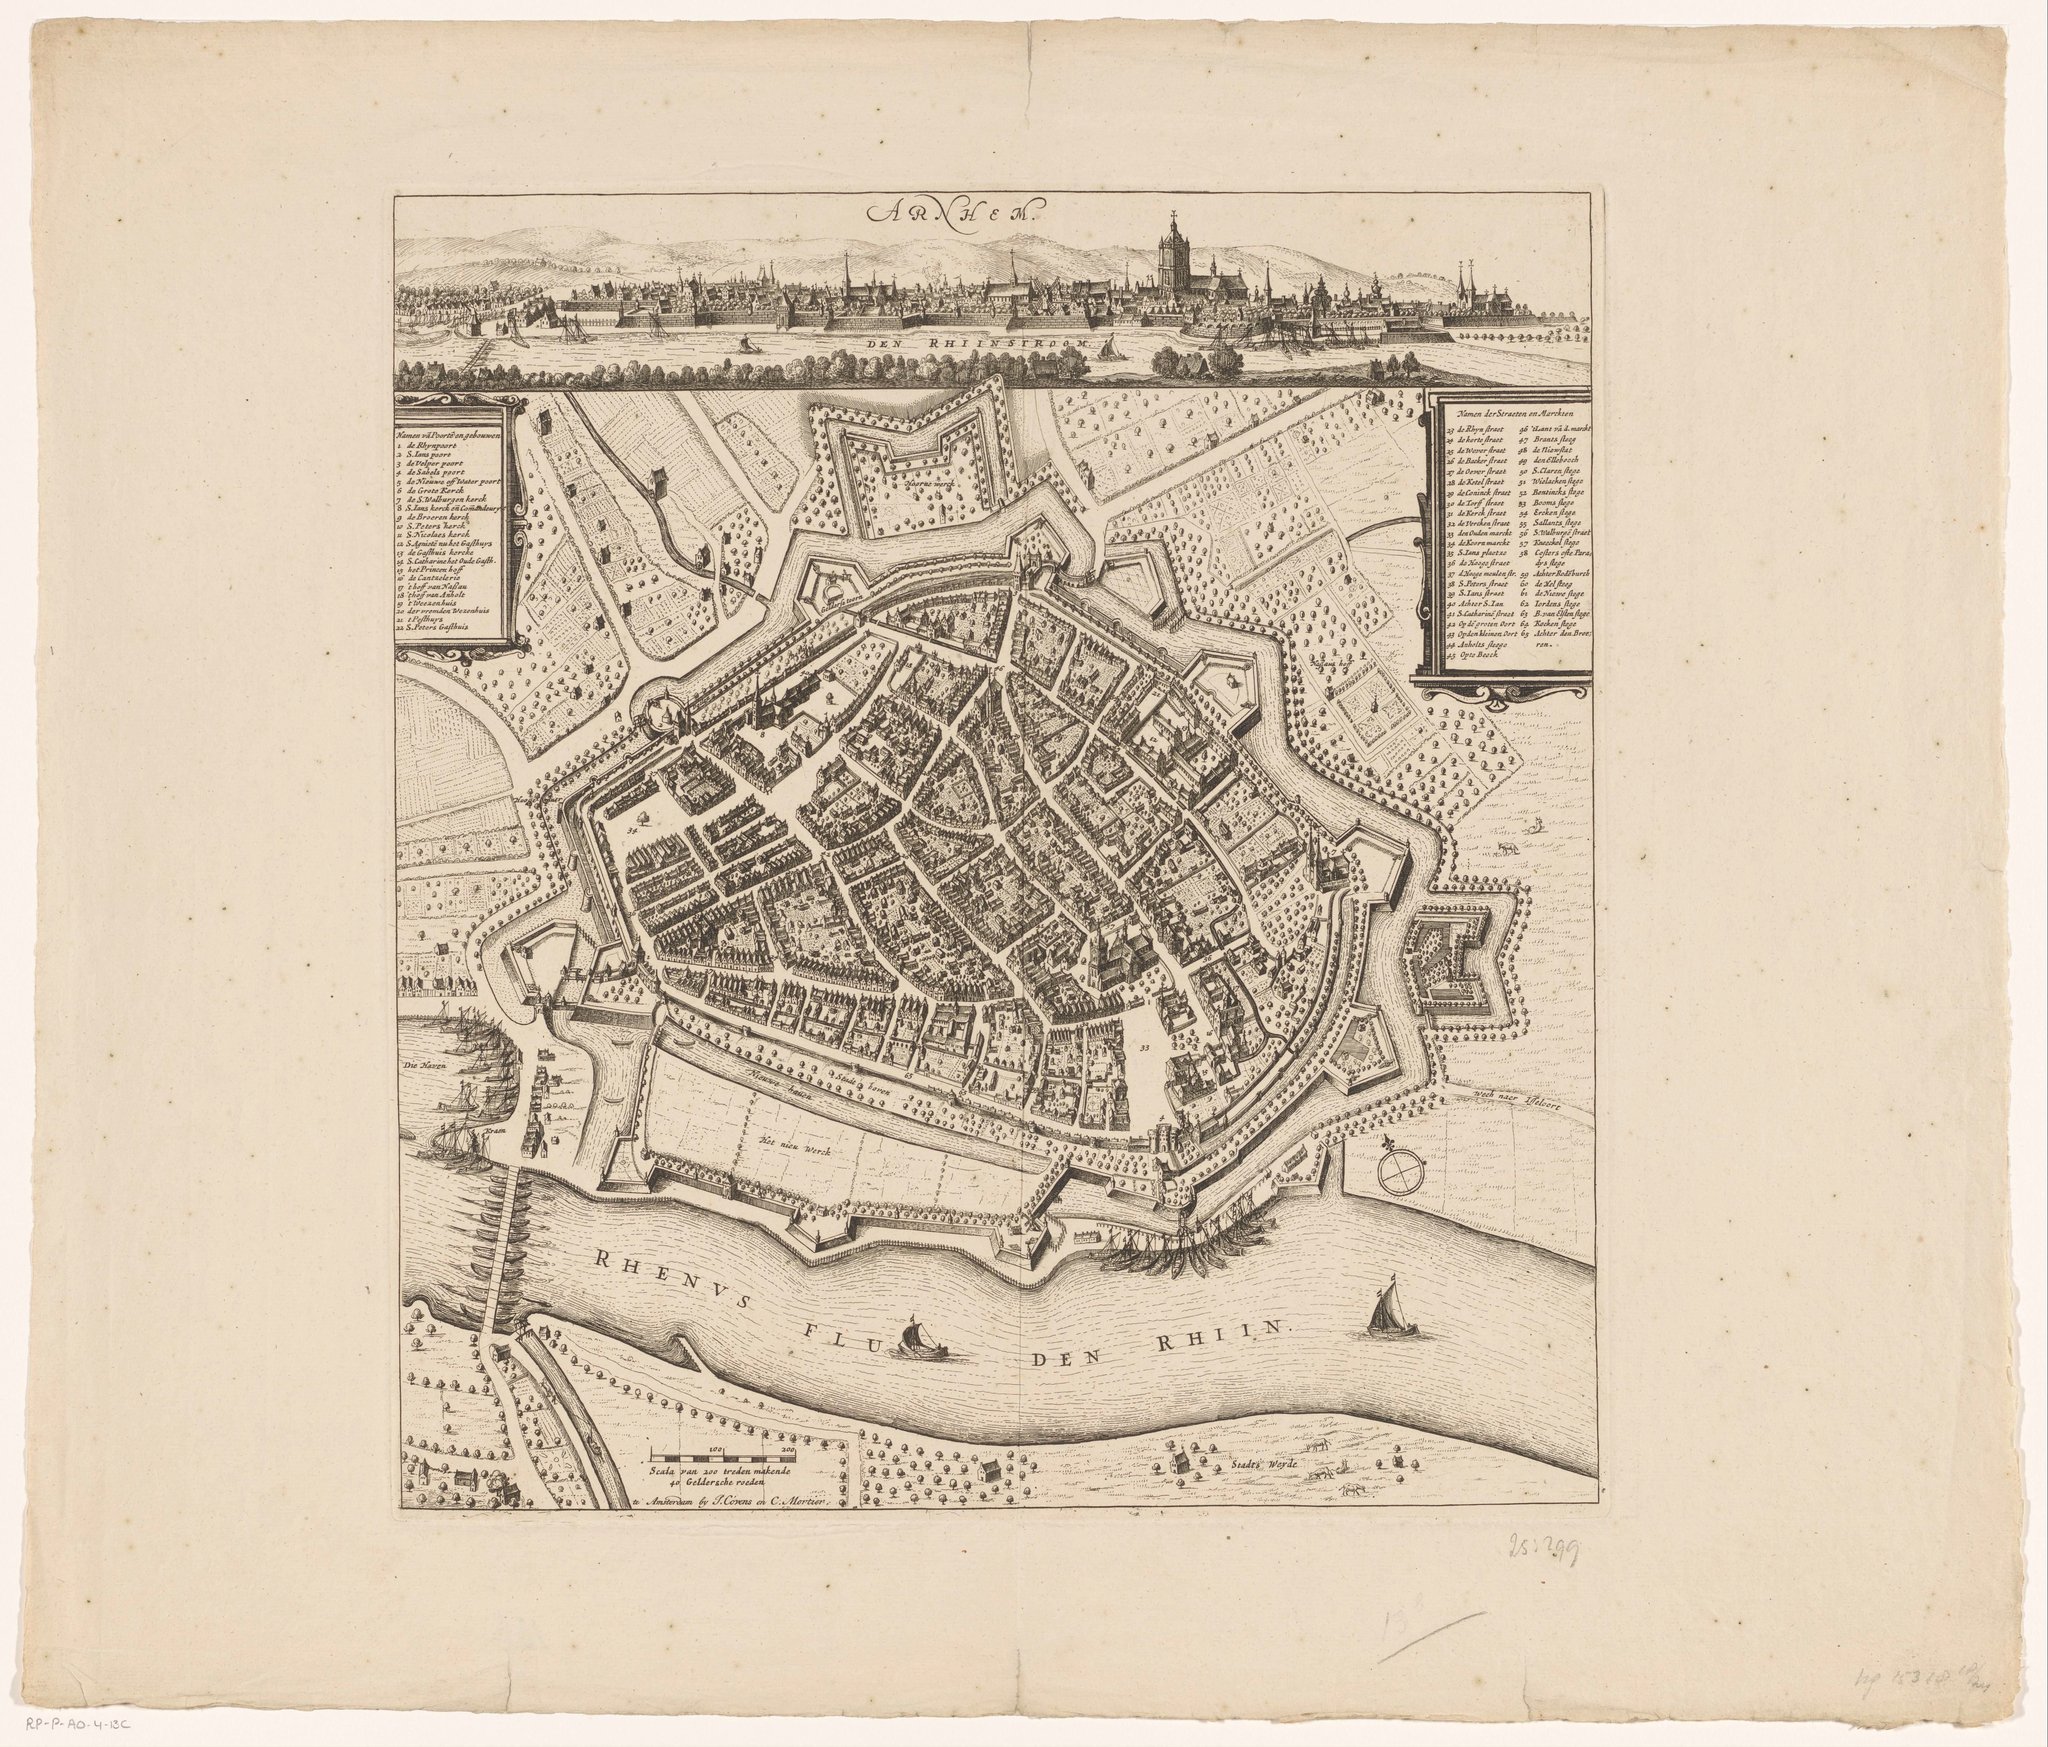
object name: print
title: Plattegrond en stadsgezicht van Arnhem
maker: Anonymous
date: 1657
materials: paper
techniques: engraving, etching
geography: amsterdam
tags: coat of arms (as symbol of the state, etc.), city-view, and landscape with man-made constructions, maps of cities, gelderland, arnhem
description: Bovenaan een stadsgezicht van Arnhem, daaronder een plattegrond in vogelvluchtperspectief. Links- en rechtsboven op de plattegrond een legenda. Rechtsonder een schaalstok: Scala van 200 treden makende 40 Geldersche roeden.